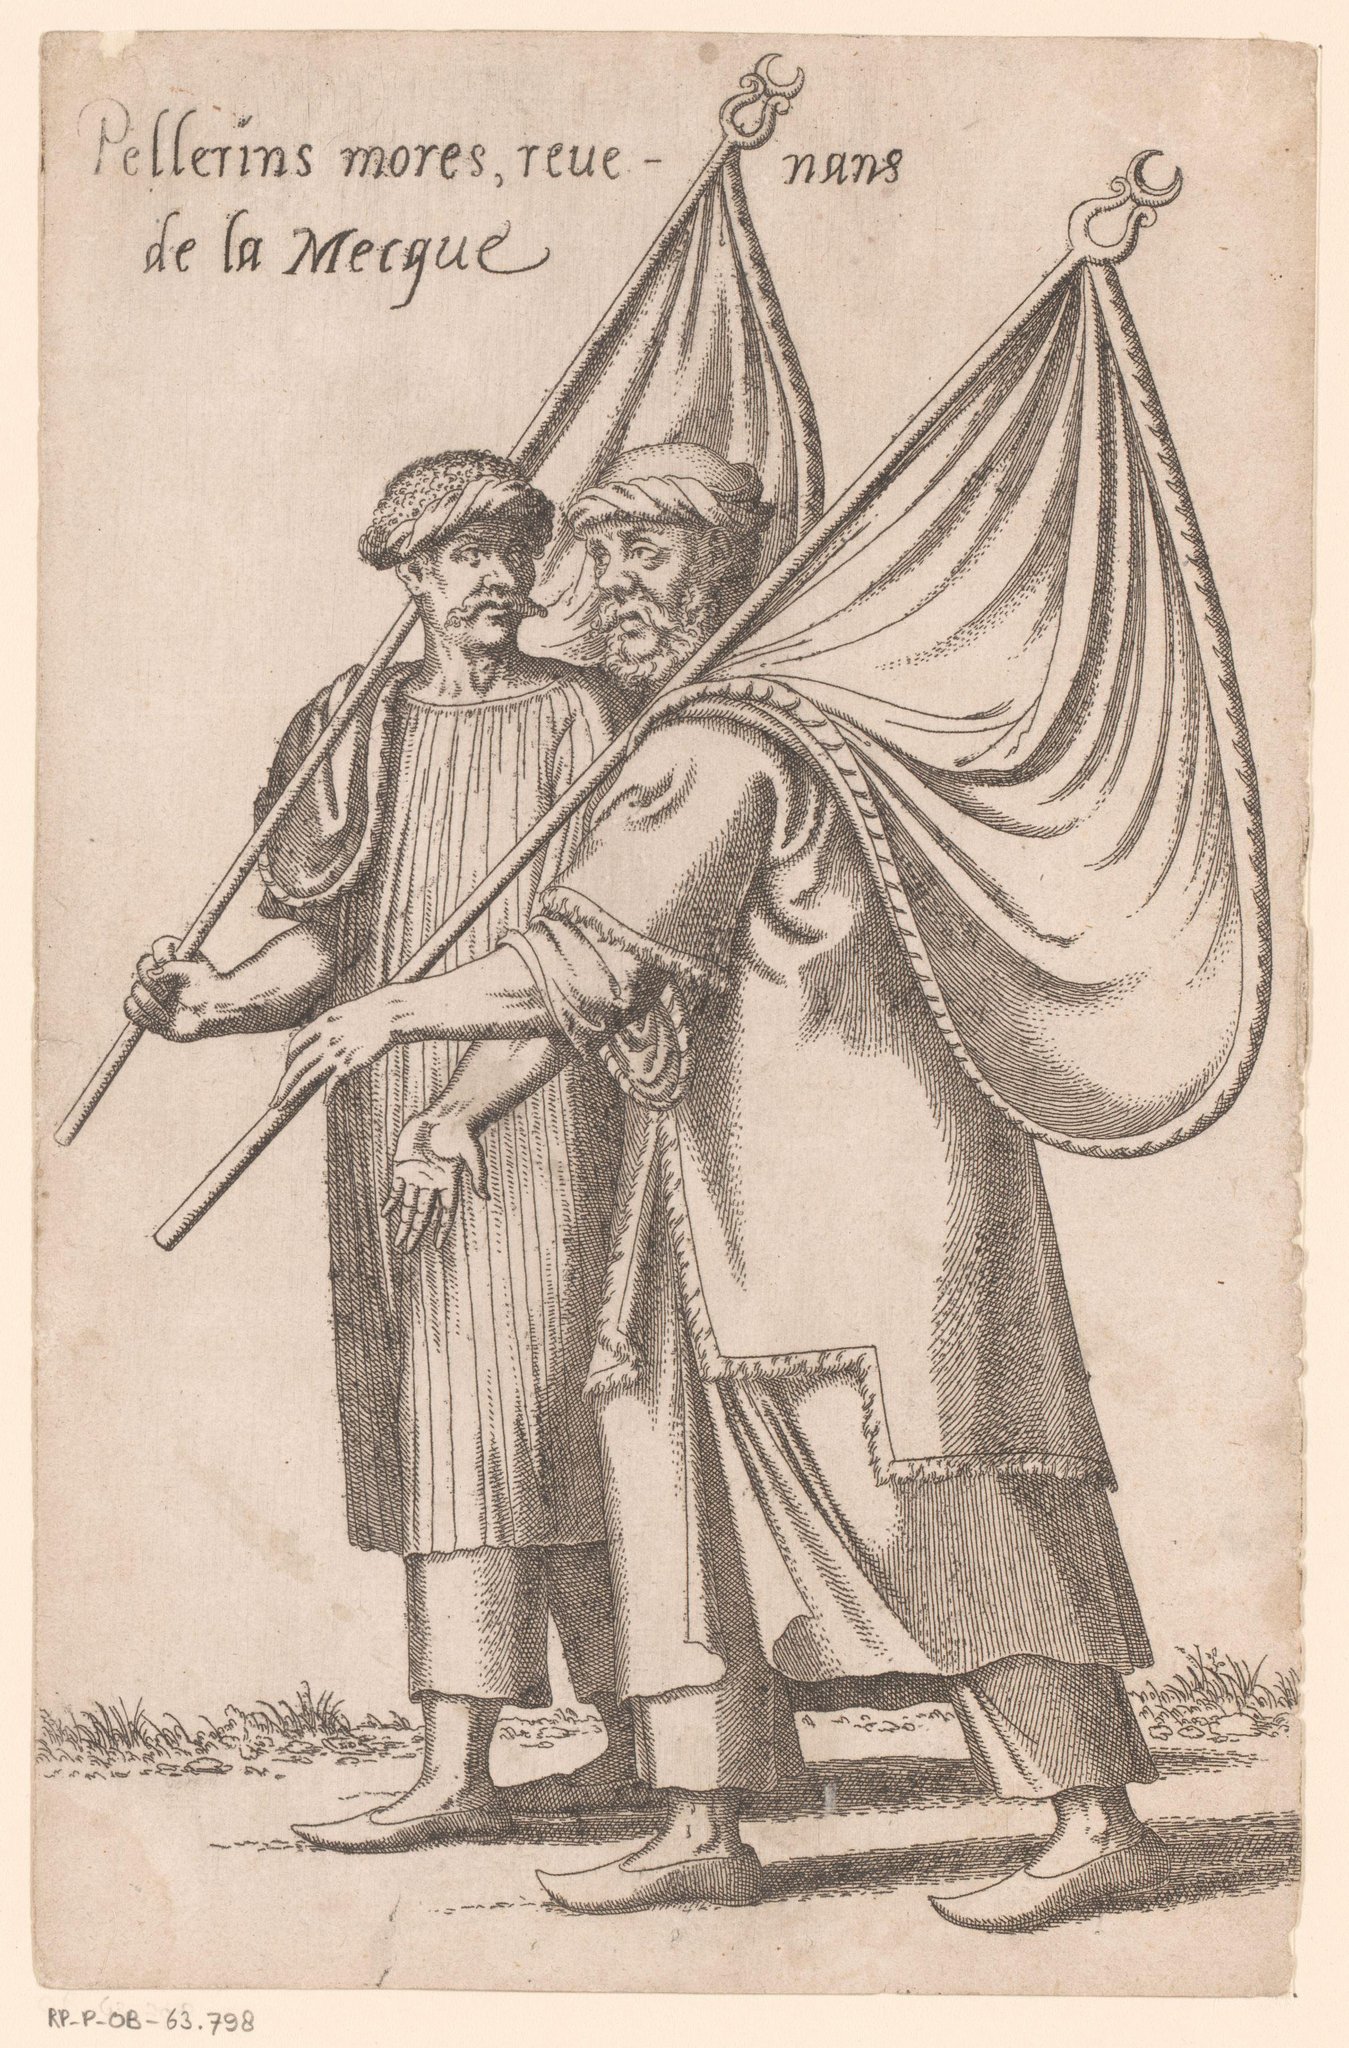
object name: print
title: Noord-Afrikaanse, islamitische pelgrims met vaandels, terugkerend uit Mekka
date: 1555-1568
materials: paper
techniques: etching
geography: lyon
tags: pilgrim(s), banner, standard (as symbol of the state, etc.)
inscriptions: collector's mark: Lugt 2228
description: Prent uit: Nicolay, Nicolas de & Ronsard, Pierre de. Les quatre premiers livres des navigations et pérégrinations orientales , de N. de Nicolay,... Avec les figures au naturel tant d'hommes que de femmes selon la diversité des nations, & de leur port, maintien & habitz. Lyon: Guillaume (I) Rouille, 1568.